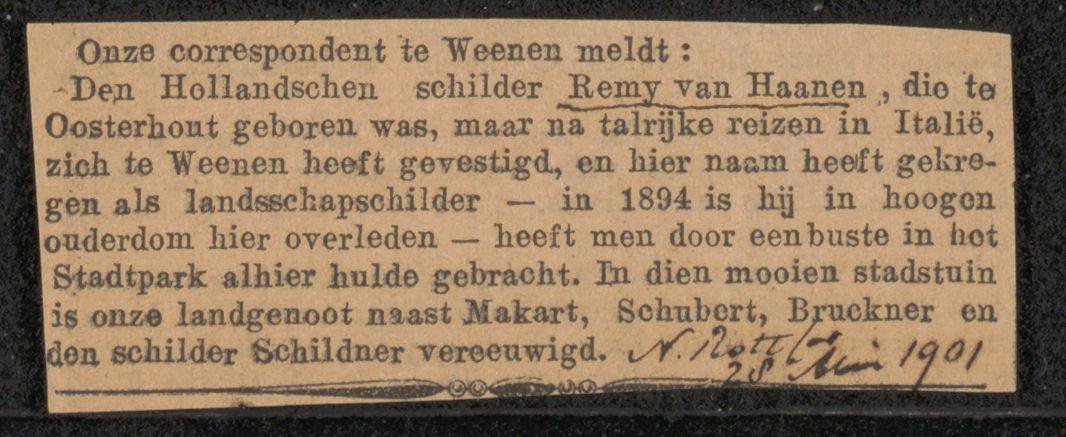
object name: newspaper clipping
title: Krantenknipsel betreffende Remigius Adrianus Haanen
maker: Anonymous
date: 1901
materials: paper, ink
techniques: printing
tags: painter, print maker, draughtsman, remigius adrianus haanen, sculpture, historical persons (portraits and scenes from the life)